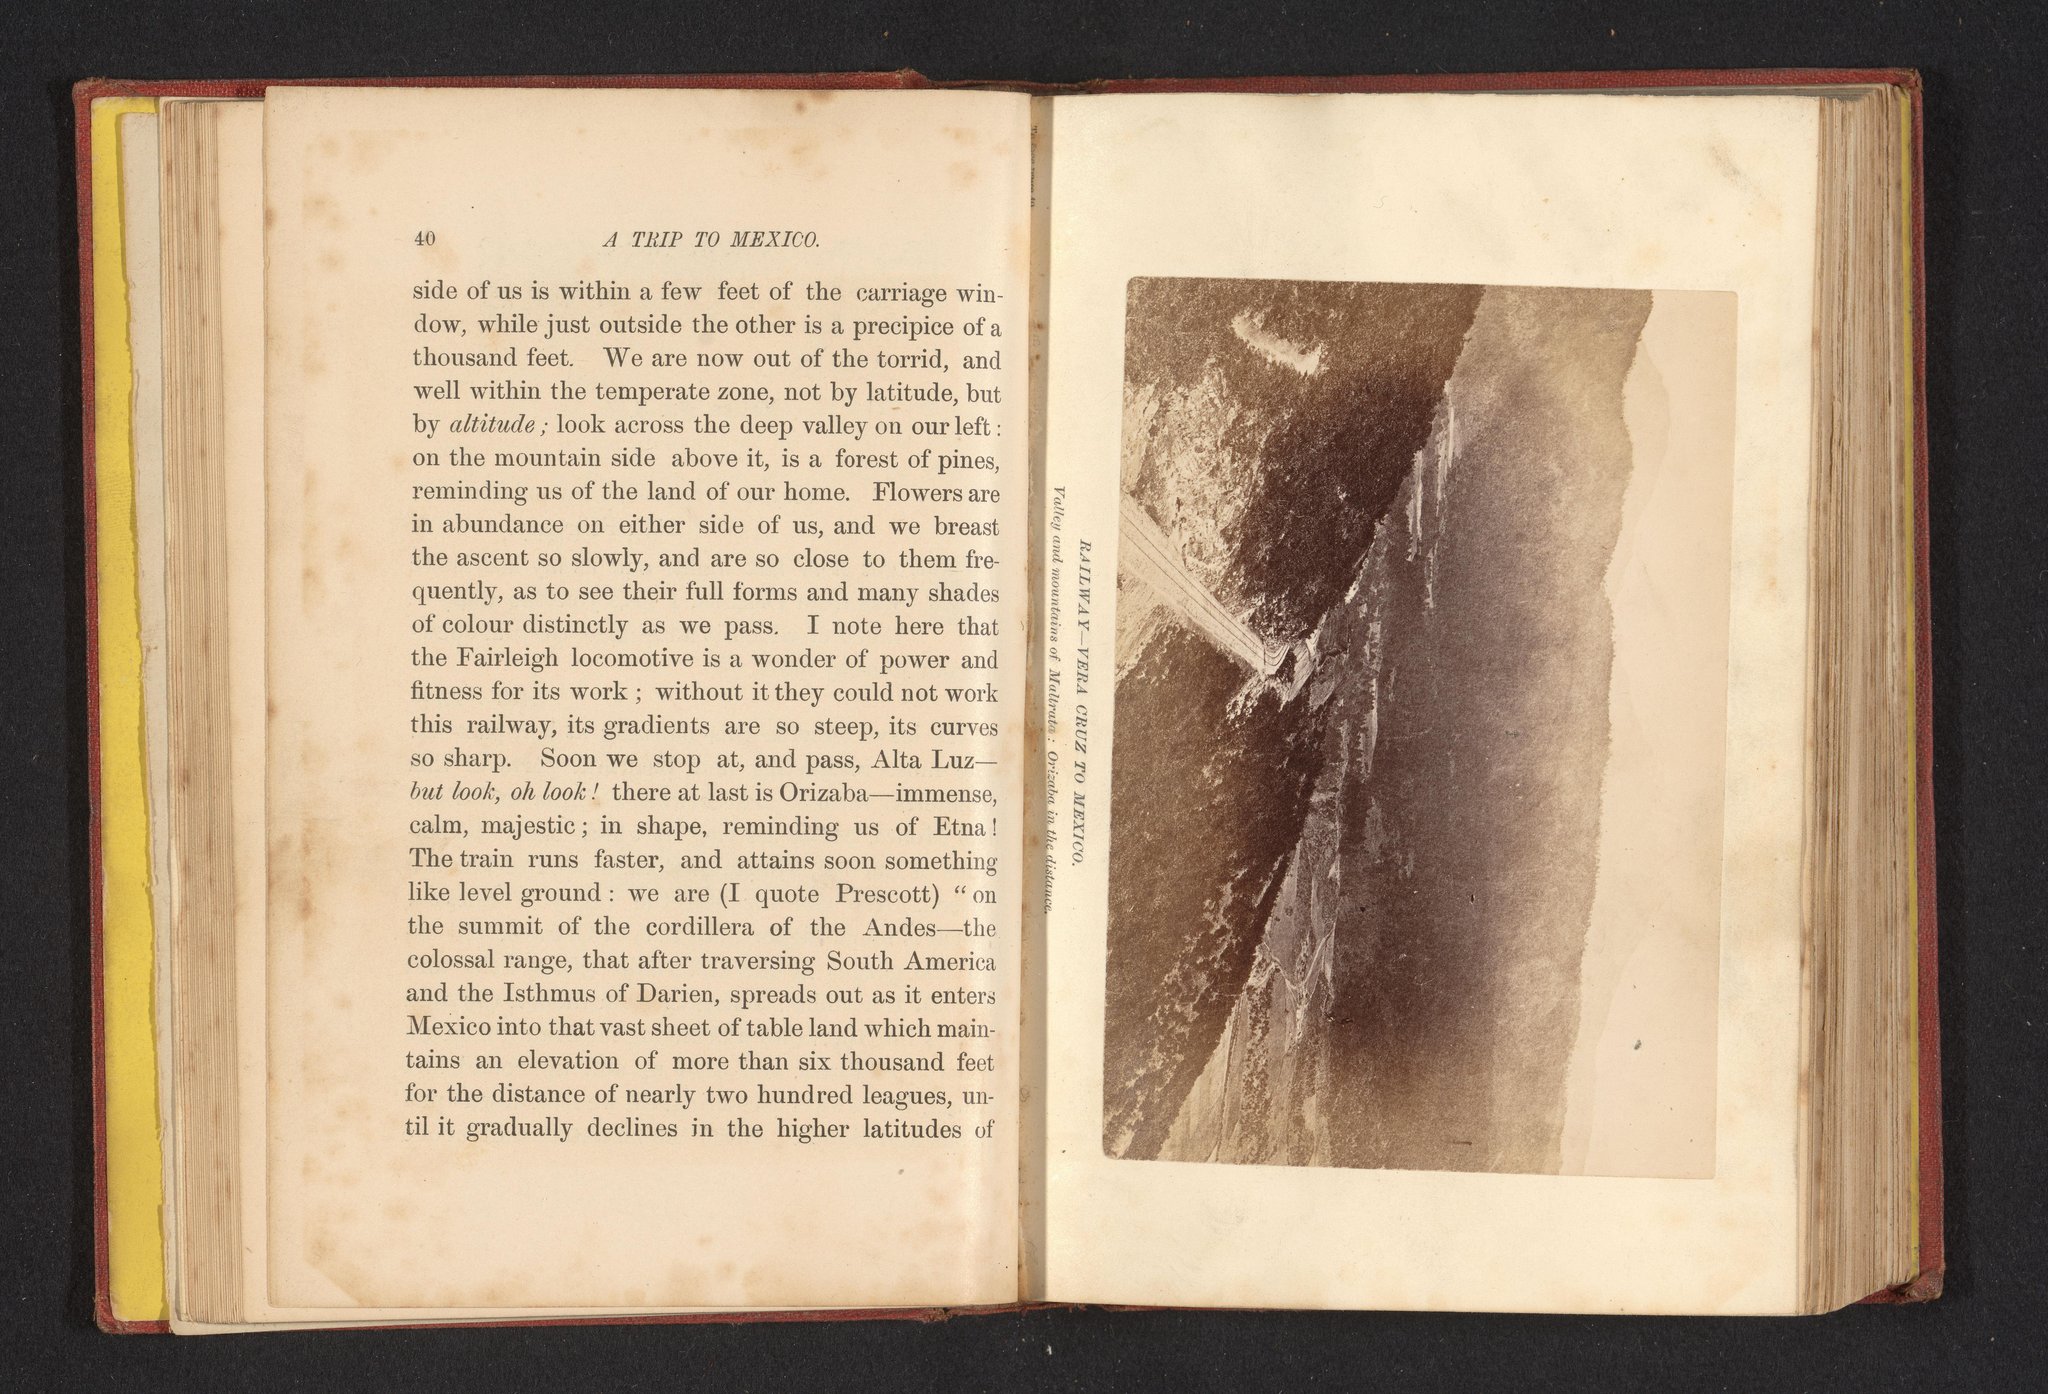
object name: page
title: Railway-Vera Cruz to Mexico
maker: Anonymous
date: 1870-1880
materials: photographic support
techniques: albumen print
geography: mexico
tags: (high) hill, railway, train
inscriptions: inscription: ‘Valley (...) in the distance.’